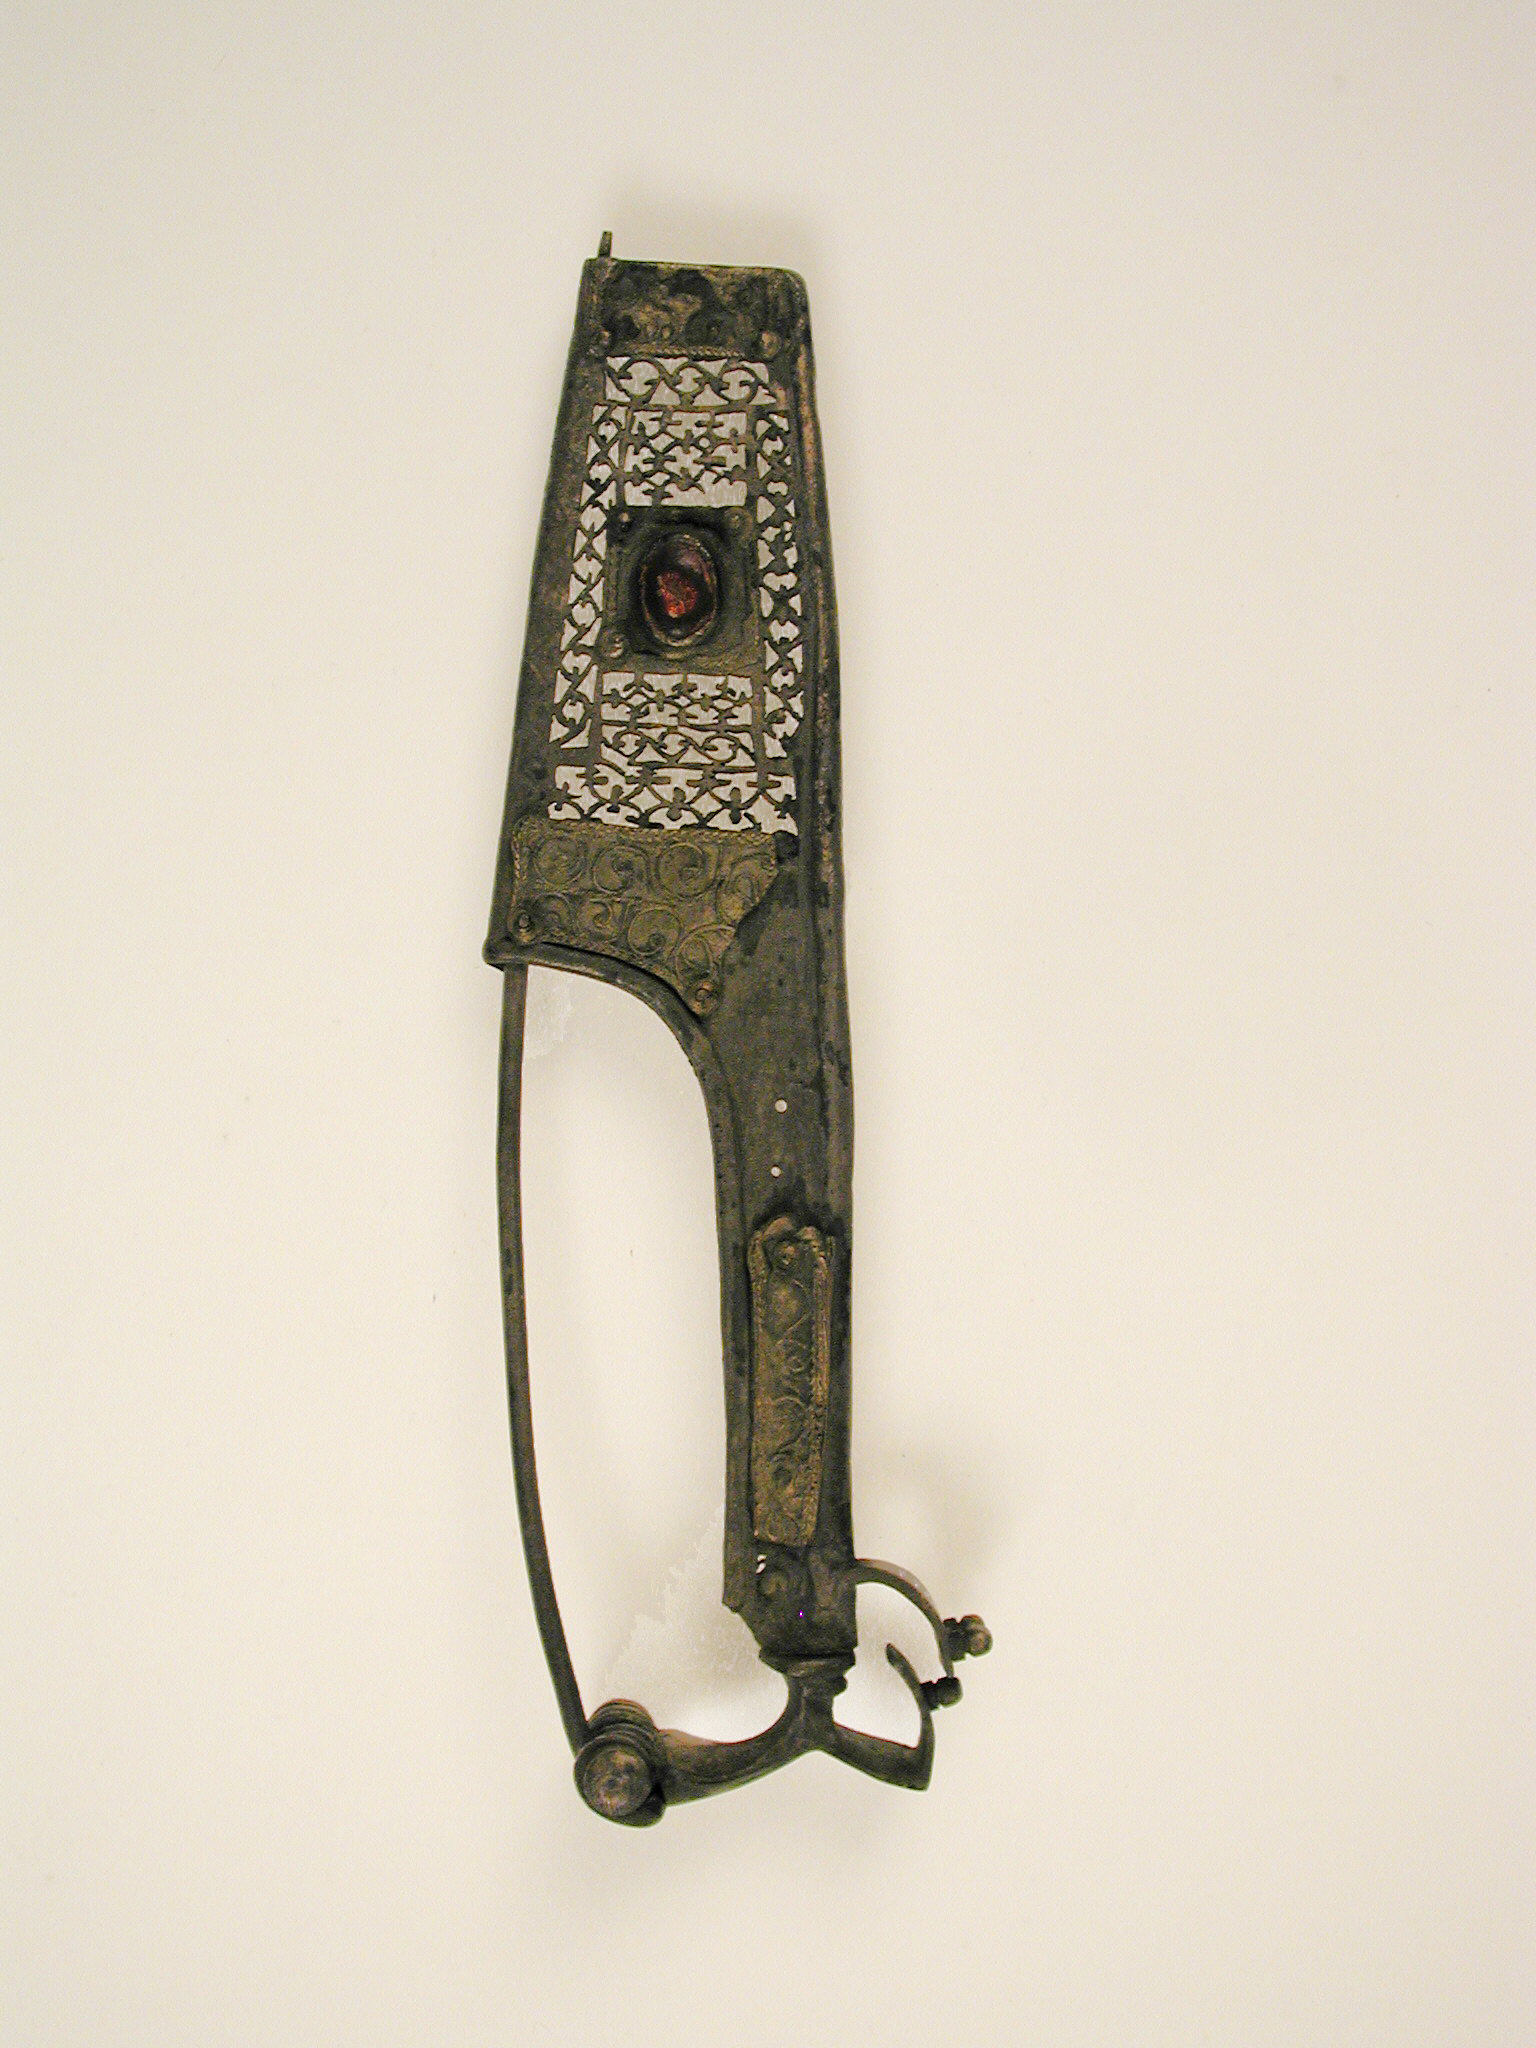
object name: brooch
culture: hungarian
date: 1901-1933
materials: gilt, glass, silver